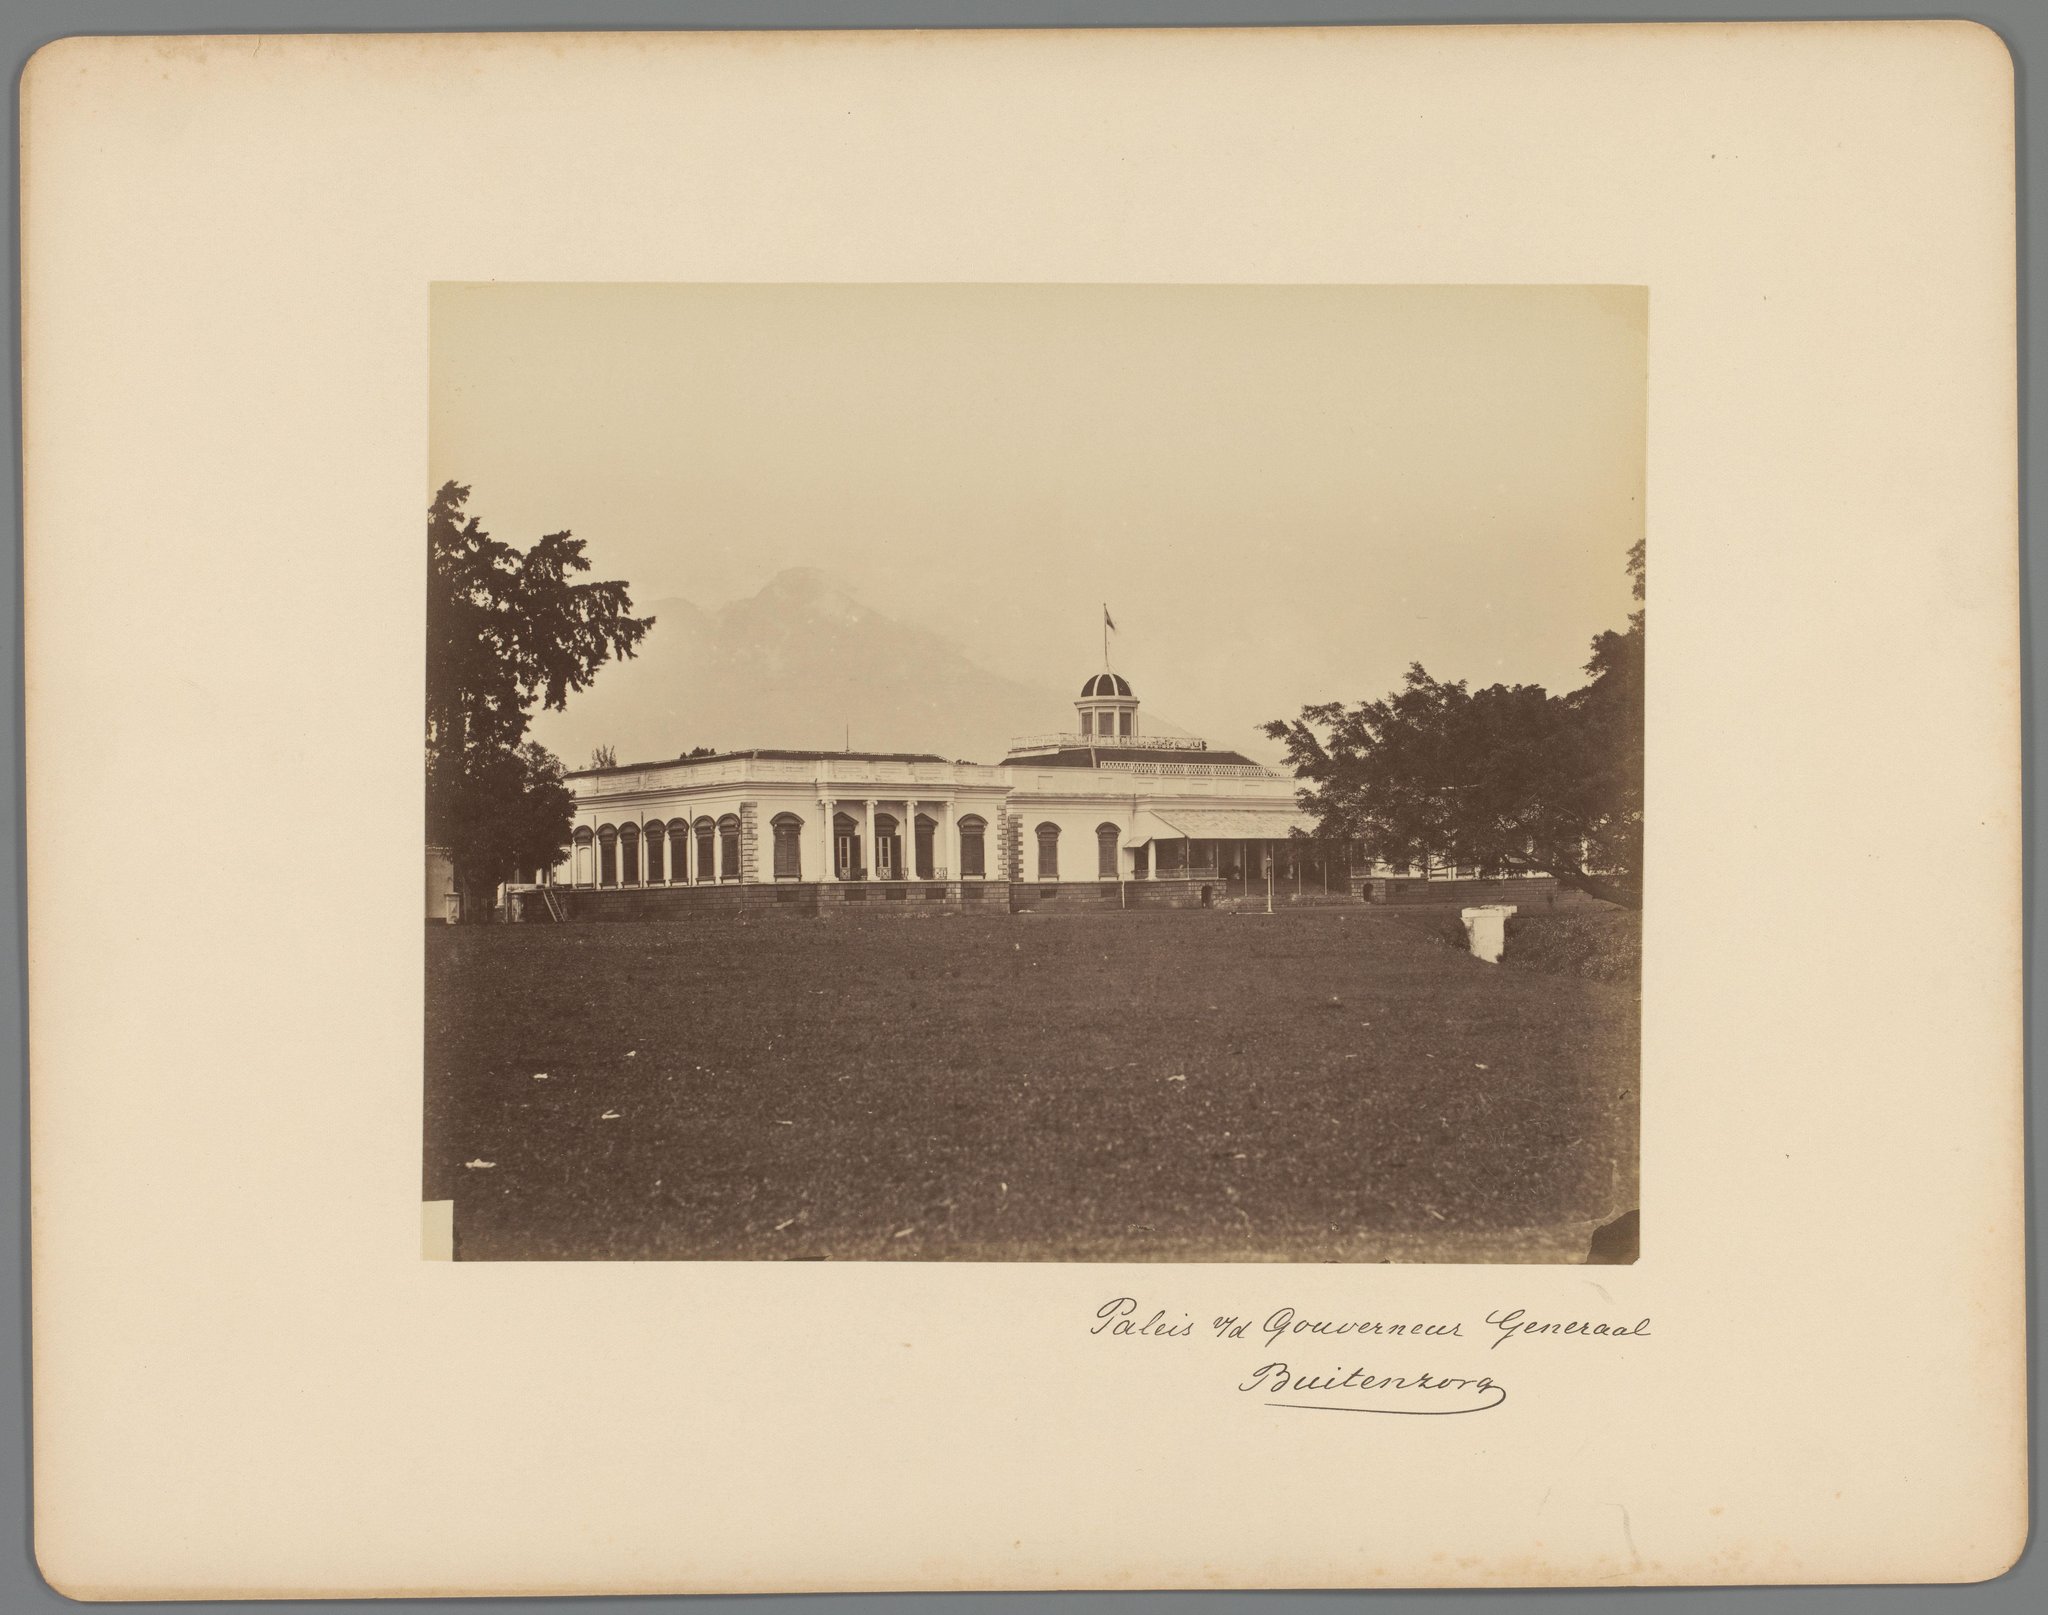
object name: photograph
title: Paleis van de Gouverneur Generaal. Buitenzorg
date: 1857-1908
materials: cardboard, paper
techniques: albumen print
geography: buitenzorg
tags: national government, exterior ~ representation of a building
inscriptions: inscription: ‘FOTO’, inscription: ‘PHOTOGRAFIEEN VAN NED: INDIE BATAVIA’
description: Deze foto zat oorspronkelijk in prentenkabinet RP-F-AA3192.